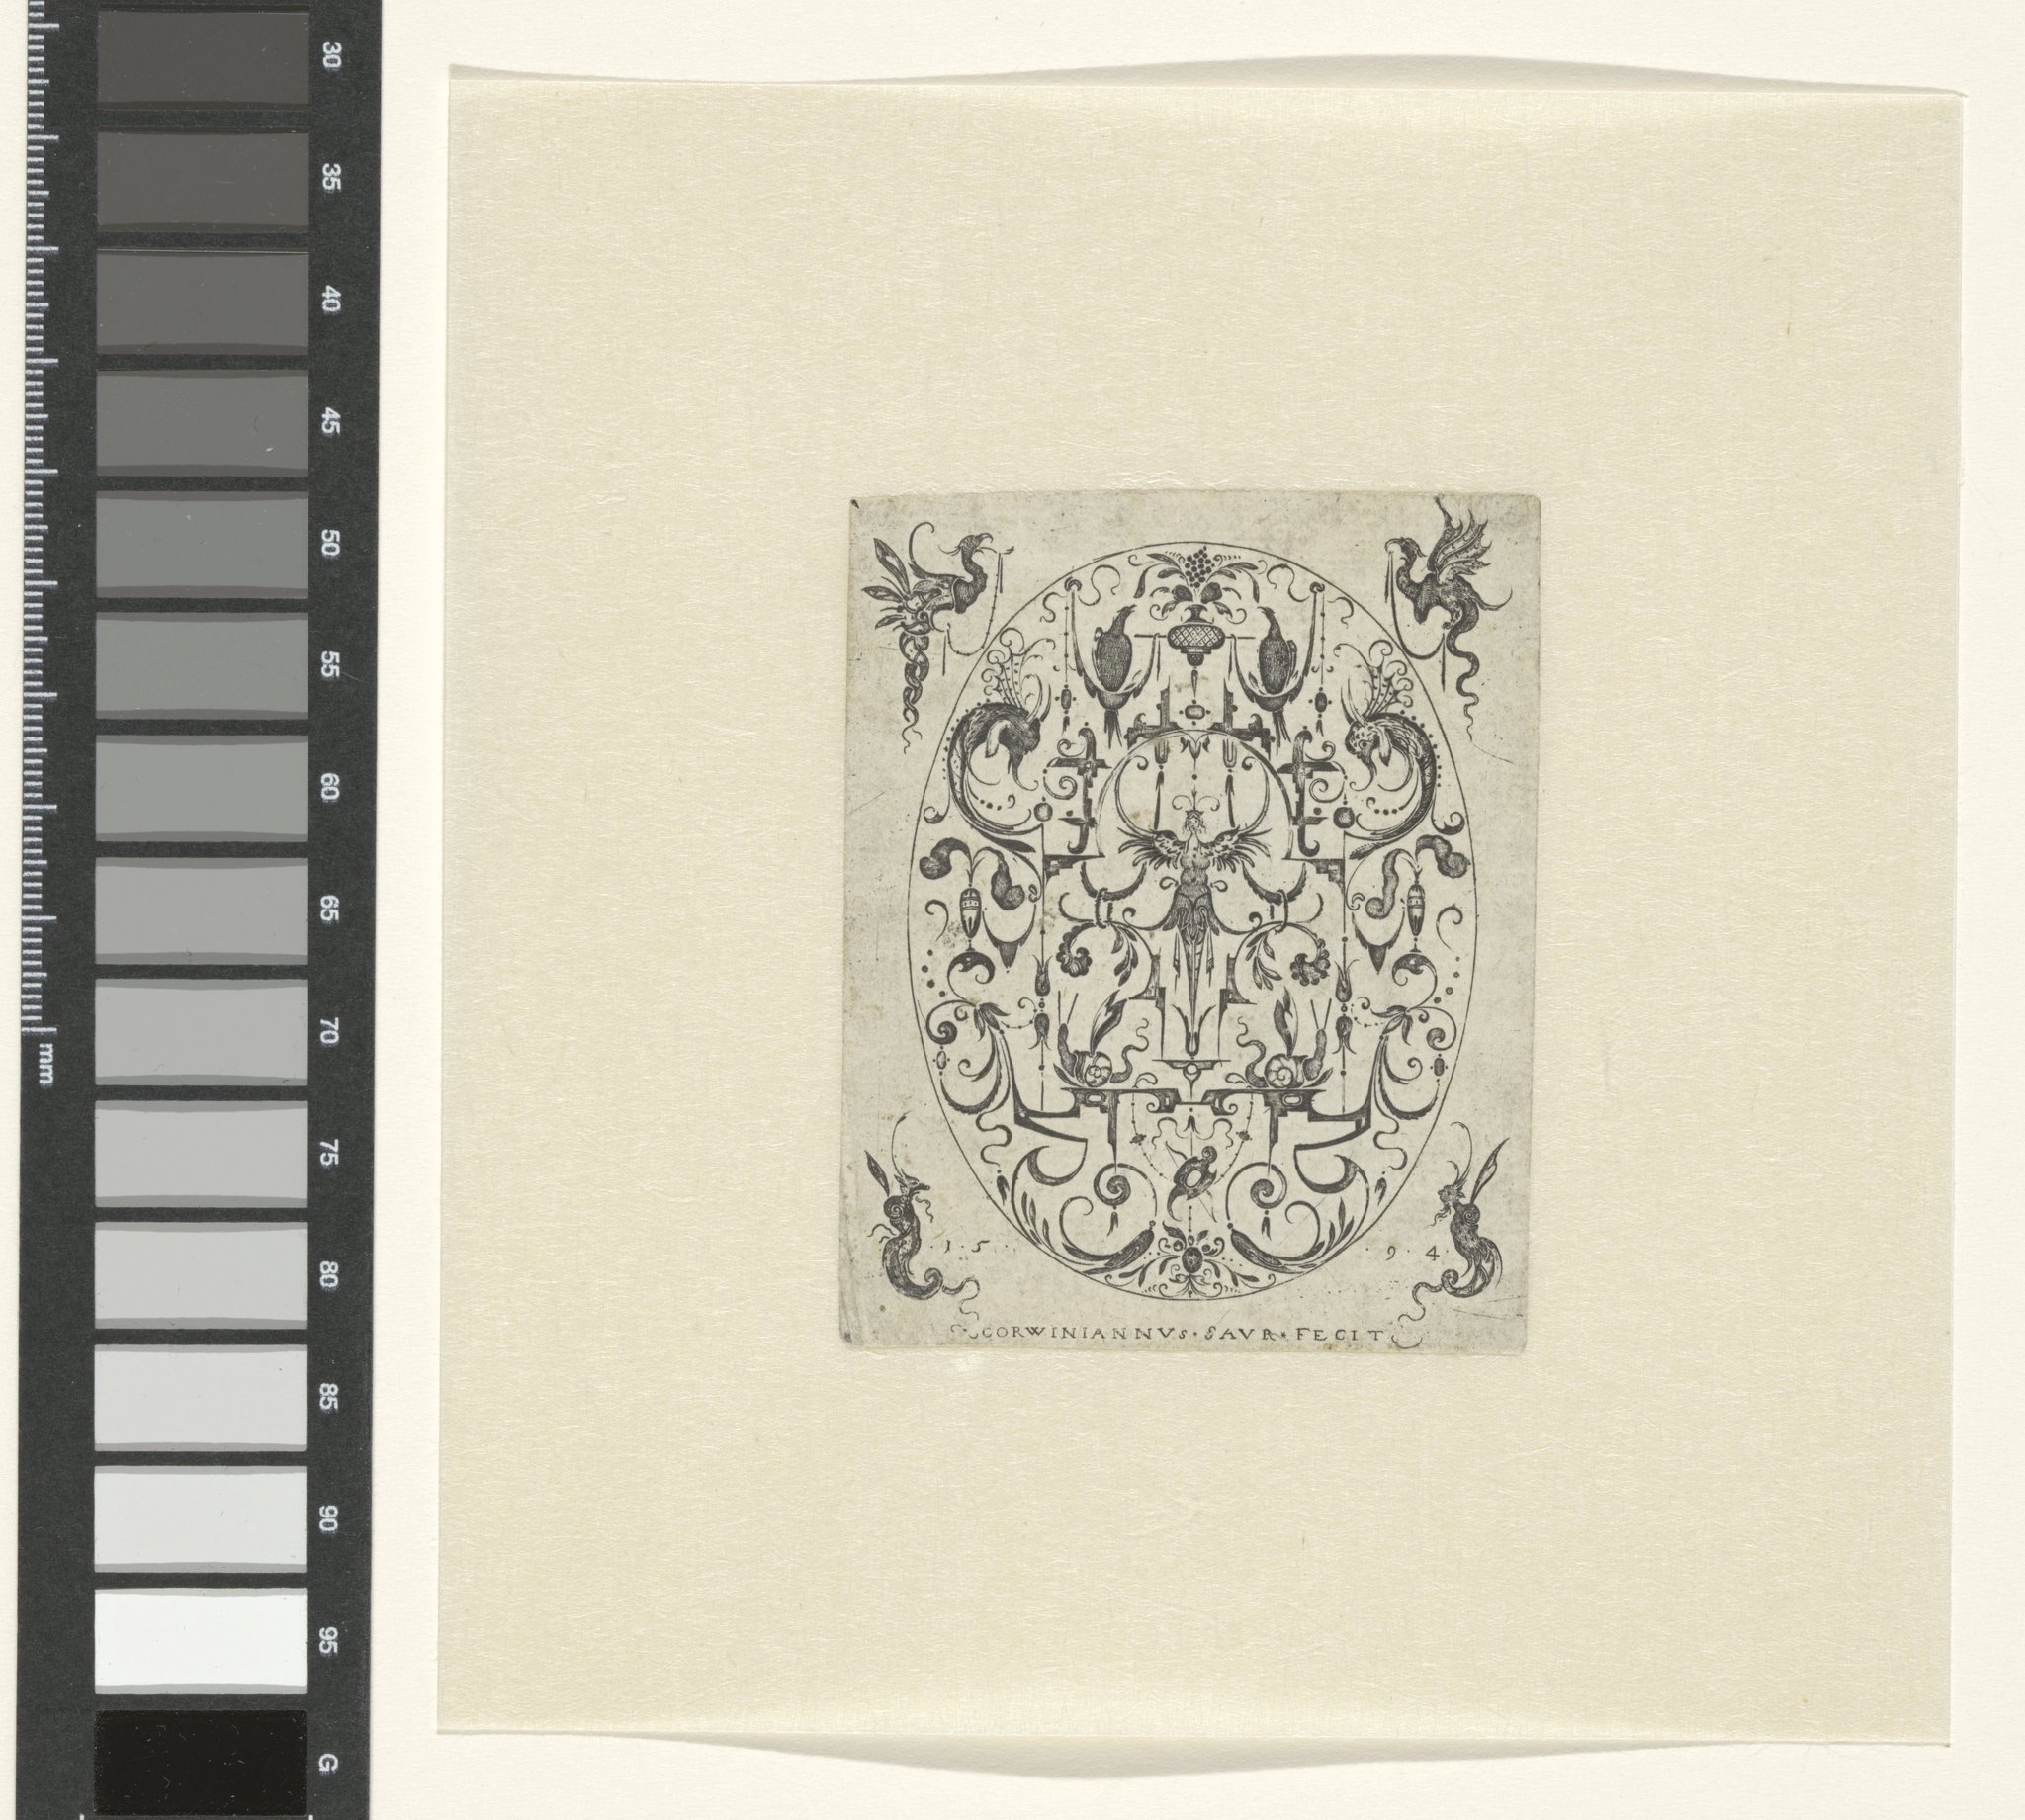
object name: ornament print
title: Ornamentprent met grotesken en monsters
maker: corbinian saur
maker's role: print maker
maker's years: -1635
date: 1594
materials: paper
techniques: engraving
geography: augsburg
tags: ornament ~ grotesque, ornament derived from animal forms, dragon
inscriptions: collector's mark: Lugt 2760, collector's mark: Lugt 2228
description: Ornamentprent met centraal een ovaal met grotesken, in de vier hoeken draken.